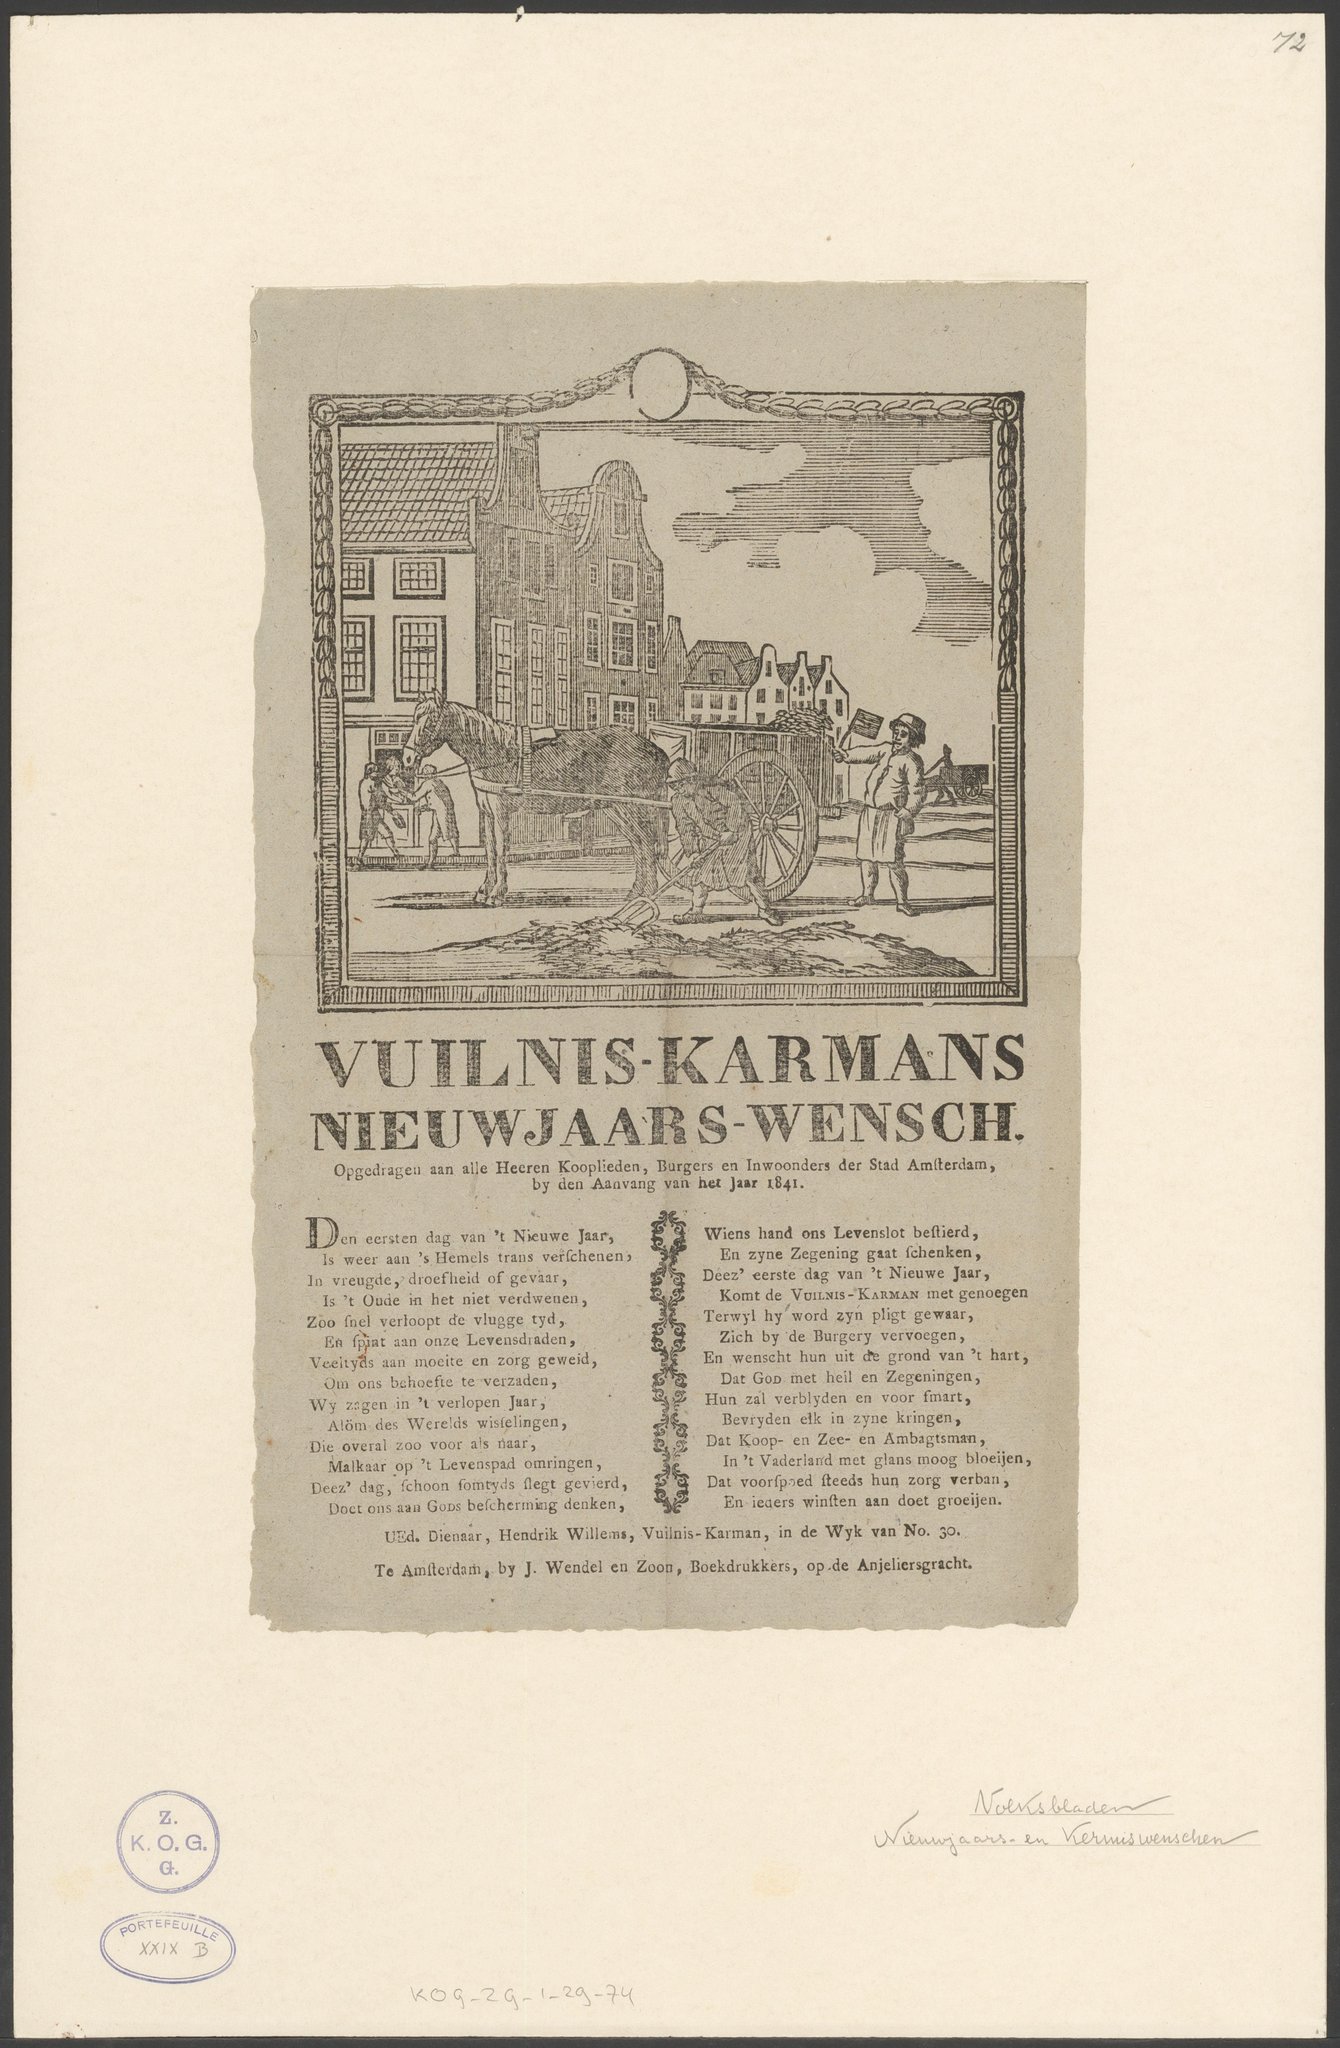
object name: print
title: Vuilnis-karmans nieuwjaars-wensch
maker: Anonymous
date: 1840-1841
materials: paper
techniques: letterpress printing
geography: amsterdam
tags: street, garbage collection, amsterdam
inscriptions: collector's mark: Lugt 1641, stamp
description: Nieuwjaarswens van de Amsterdamse vuilnismannen voor het jaar 1841. Gezicht in een straat te Amsterdam waar een man het vuil van de straat schept en een andere man met de ratel draait. Twee andere mannen halen bij een huis geld op. Met gedicht in twee kolommen. Van de vuilniskarman in de wijk no. 30: Hendrik Willems. Onderwerpsrubrieken binnen de Atlas Zeden en Gewoonten: Zeden en gewoonten in engeren zin, Volksleven, Volksbladen, Nieuwjaars- en Kerstwenschen, Amsterdam.